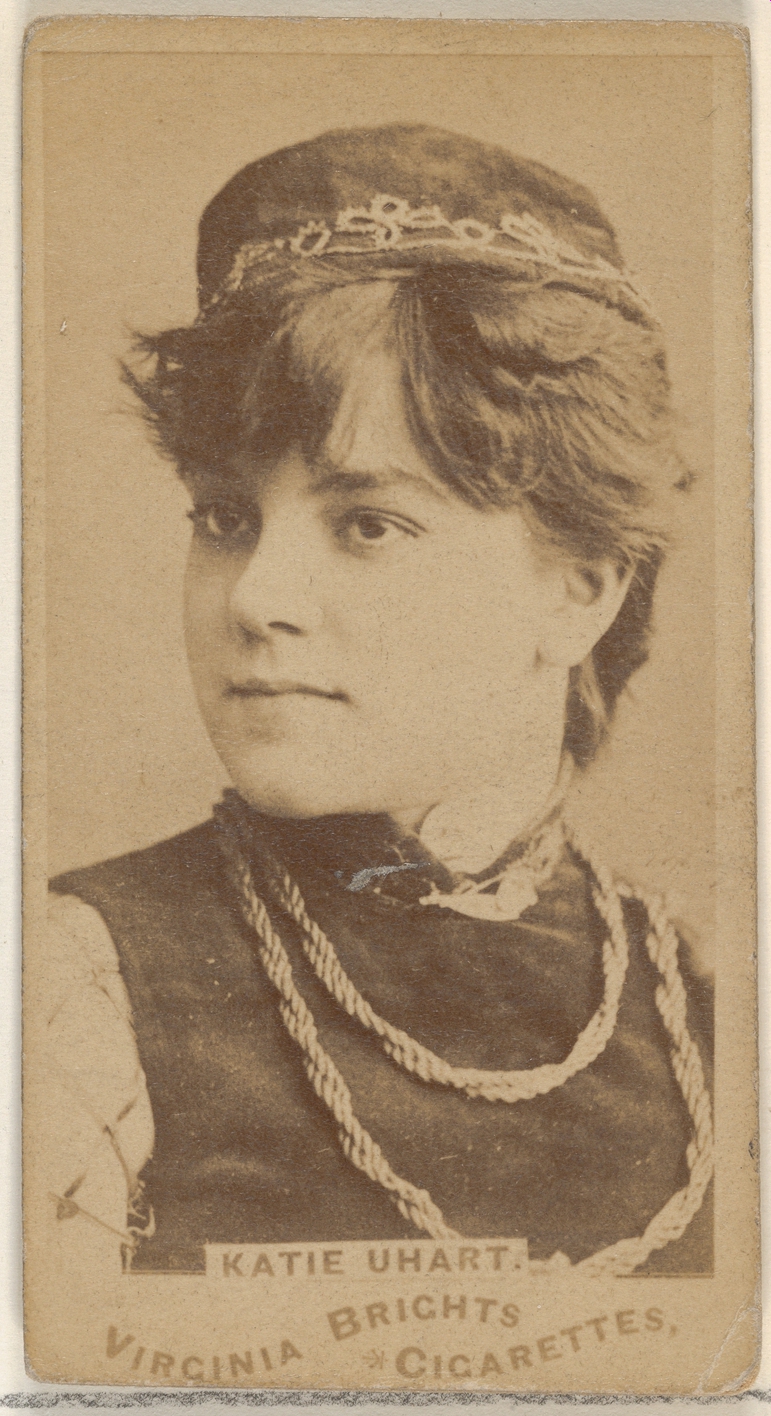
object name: photograph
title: Katie Uhart, from the Actors and Actresses series (N45, Type 1) for Virginia Brights Cigarettes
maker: allen & ginter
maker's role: publisher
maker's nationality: american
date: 1888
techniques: albumen silver print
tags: portraits,women,actresses